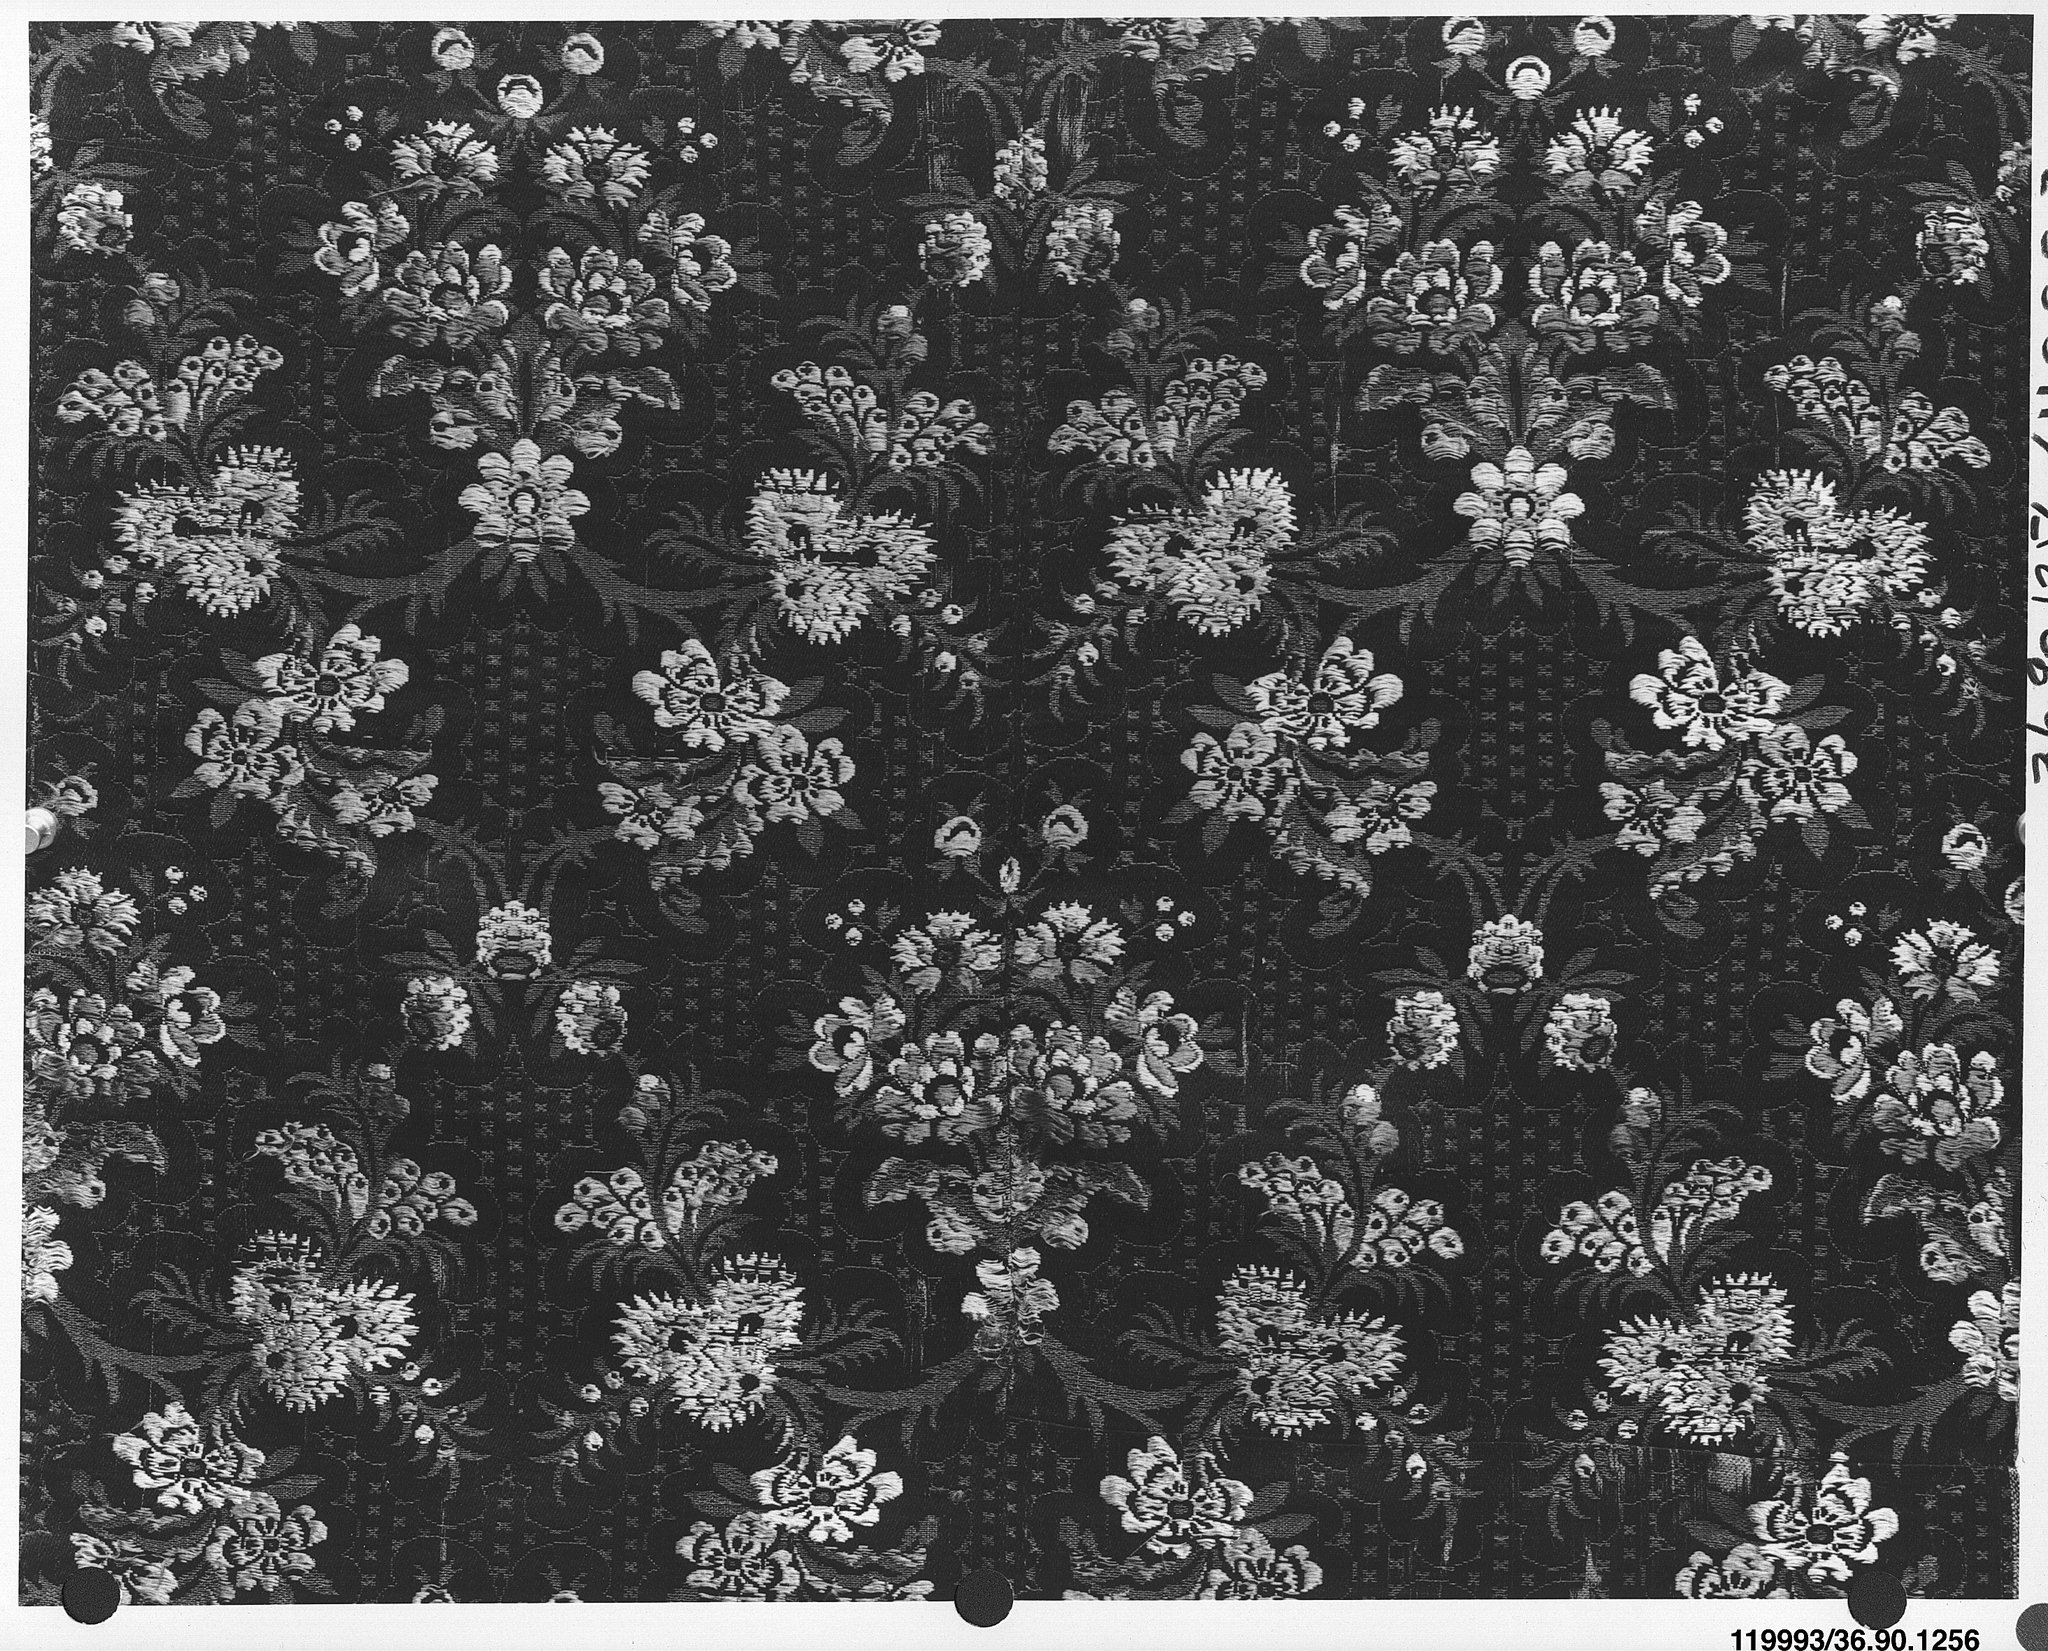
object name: piece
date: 1750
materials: cotton, silk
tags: flowers,leaves